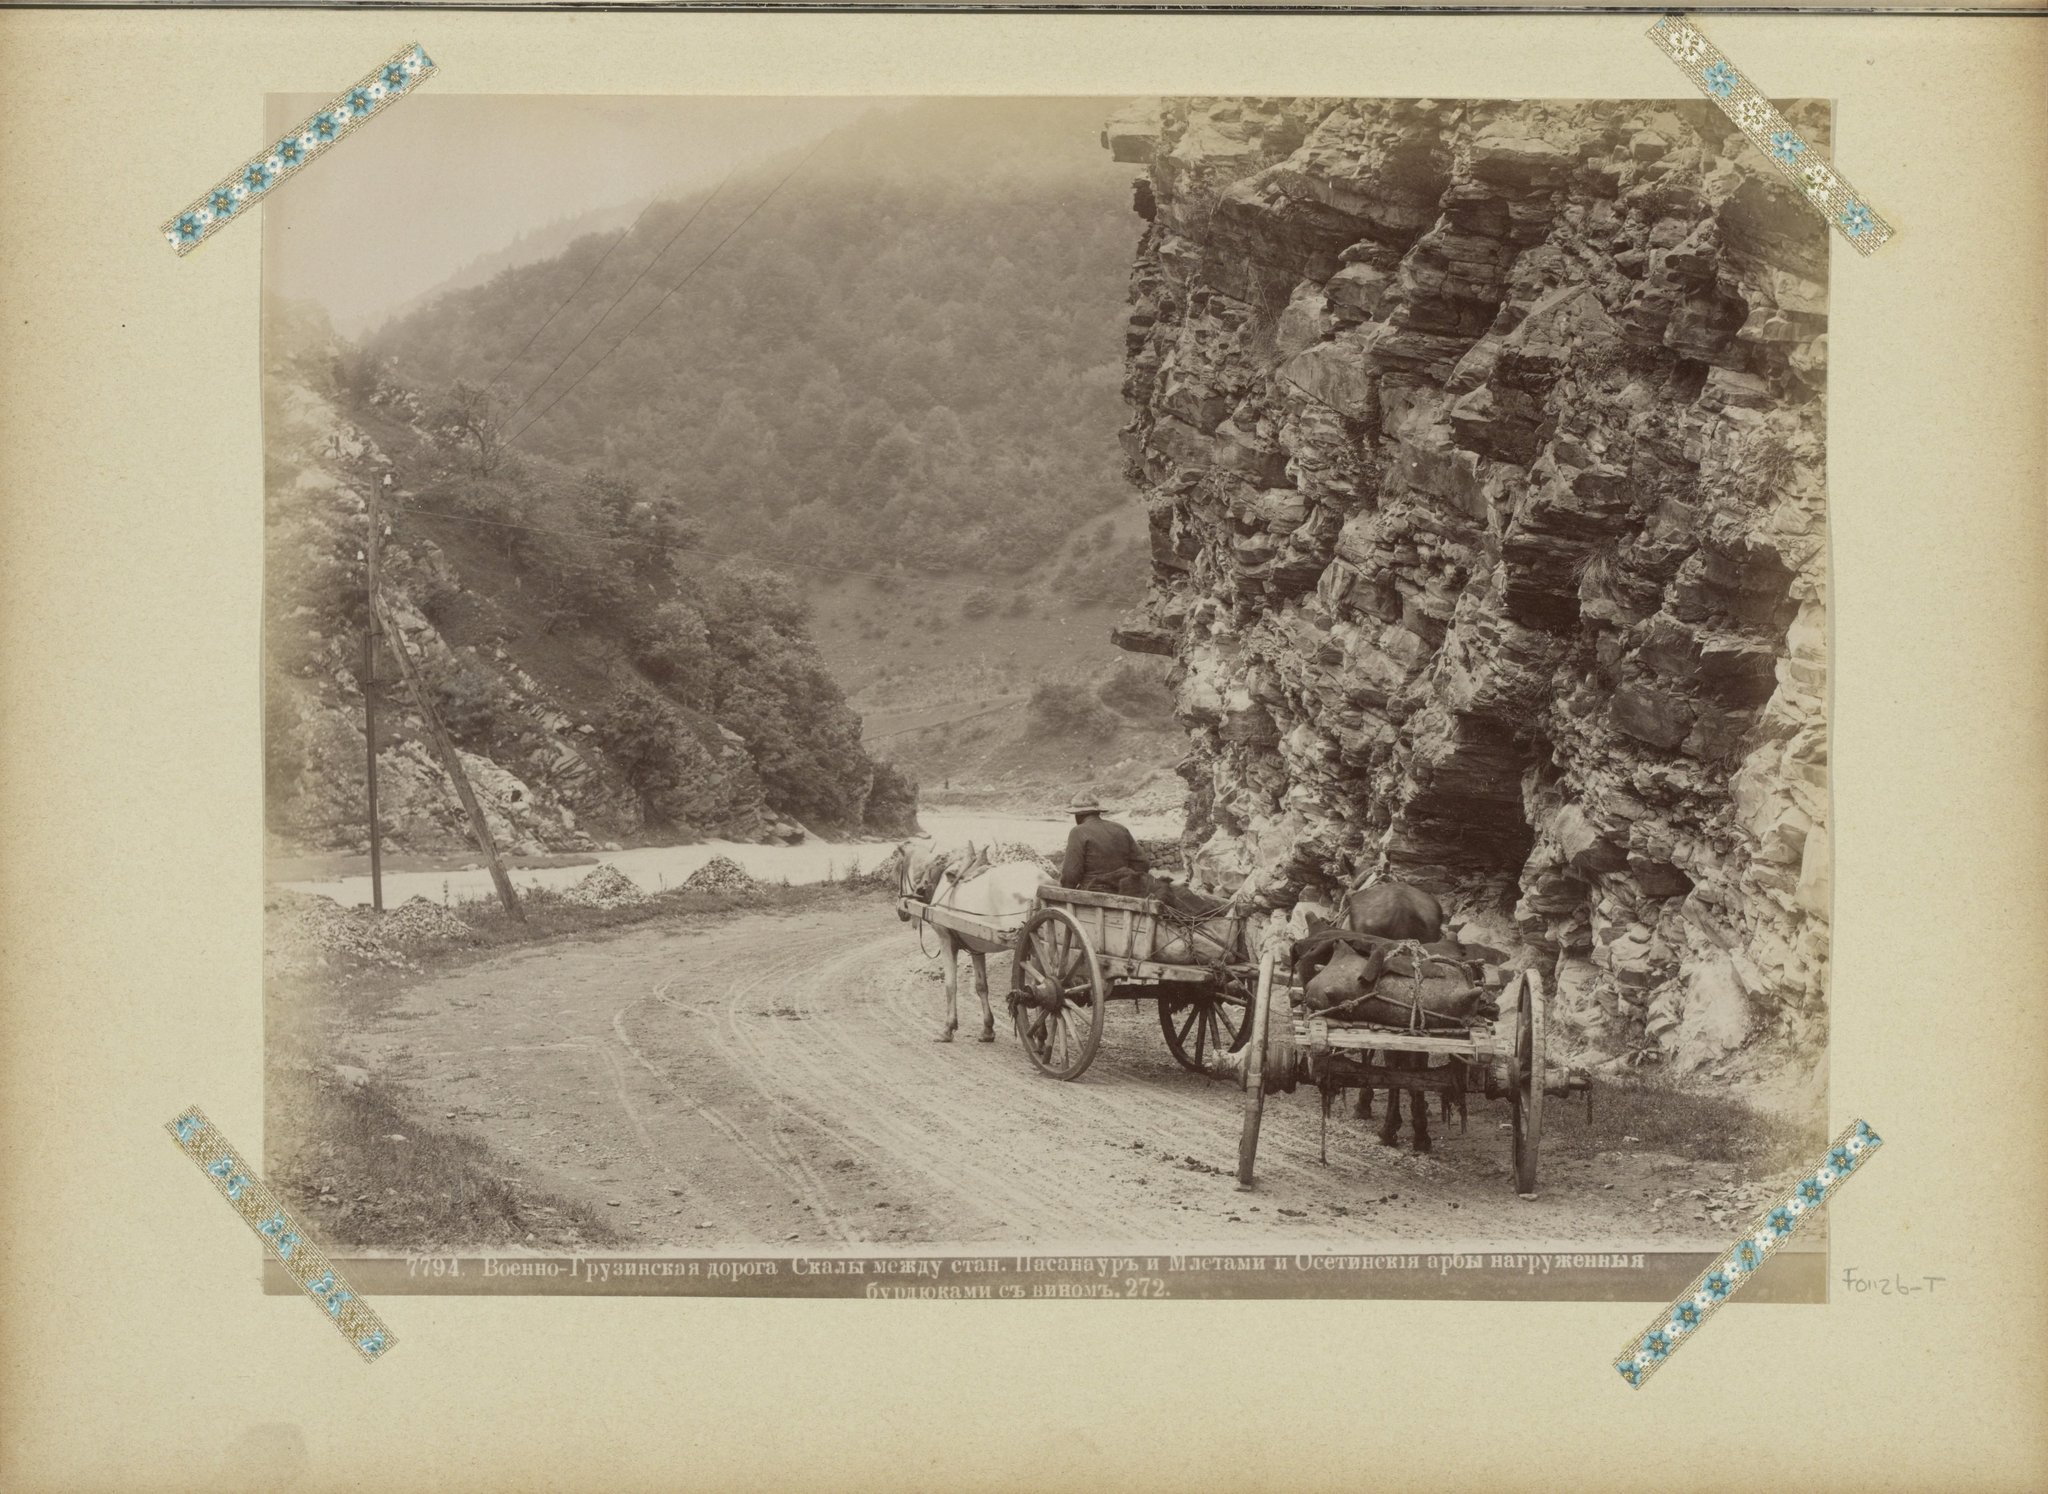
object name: photograph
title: Paardenkarren op een militaire weg langs een rivier in Georgië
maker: dimitri ivanovitch ermakov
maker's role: fotograaf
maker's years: 1845-1916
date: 1890-1900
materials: photographic support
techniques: albumen print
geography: georgia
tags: two-wheeled, animal-drawn vehicle, road, path, rock-formations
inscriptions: number: ‘272’, number: ‘7794’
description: Onderdeel van Fotoalbum met opnames van bezienswaardigheden in Georgië, Sint-Petersburg en Moskou.